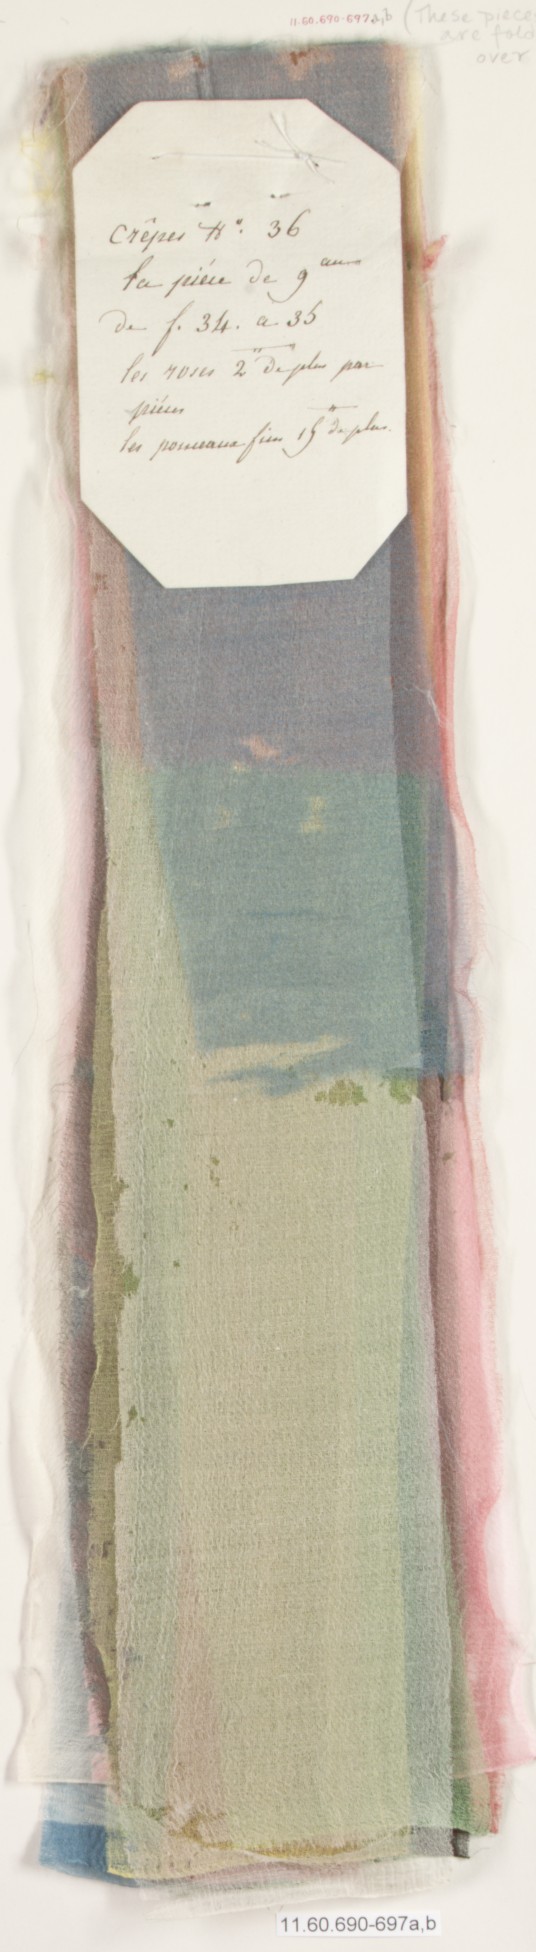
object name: sample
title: Samples (9)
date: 1801-1833